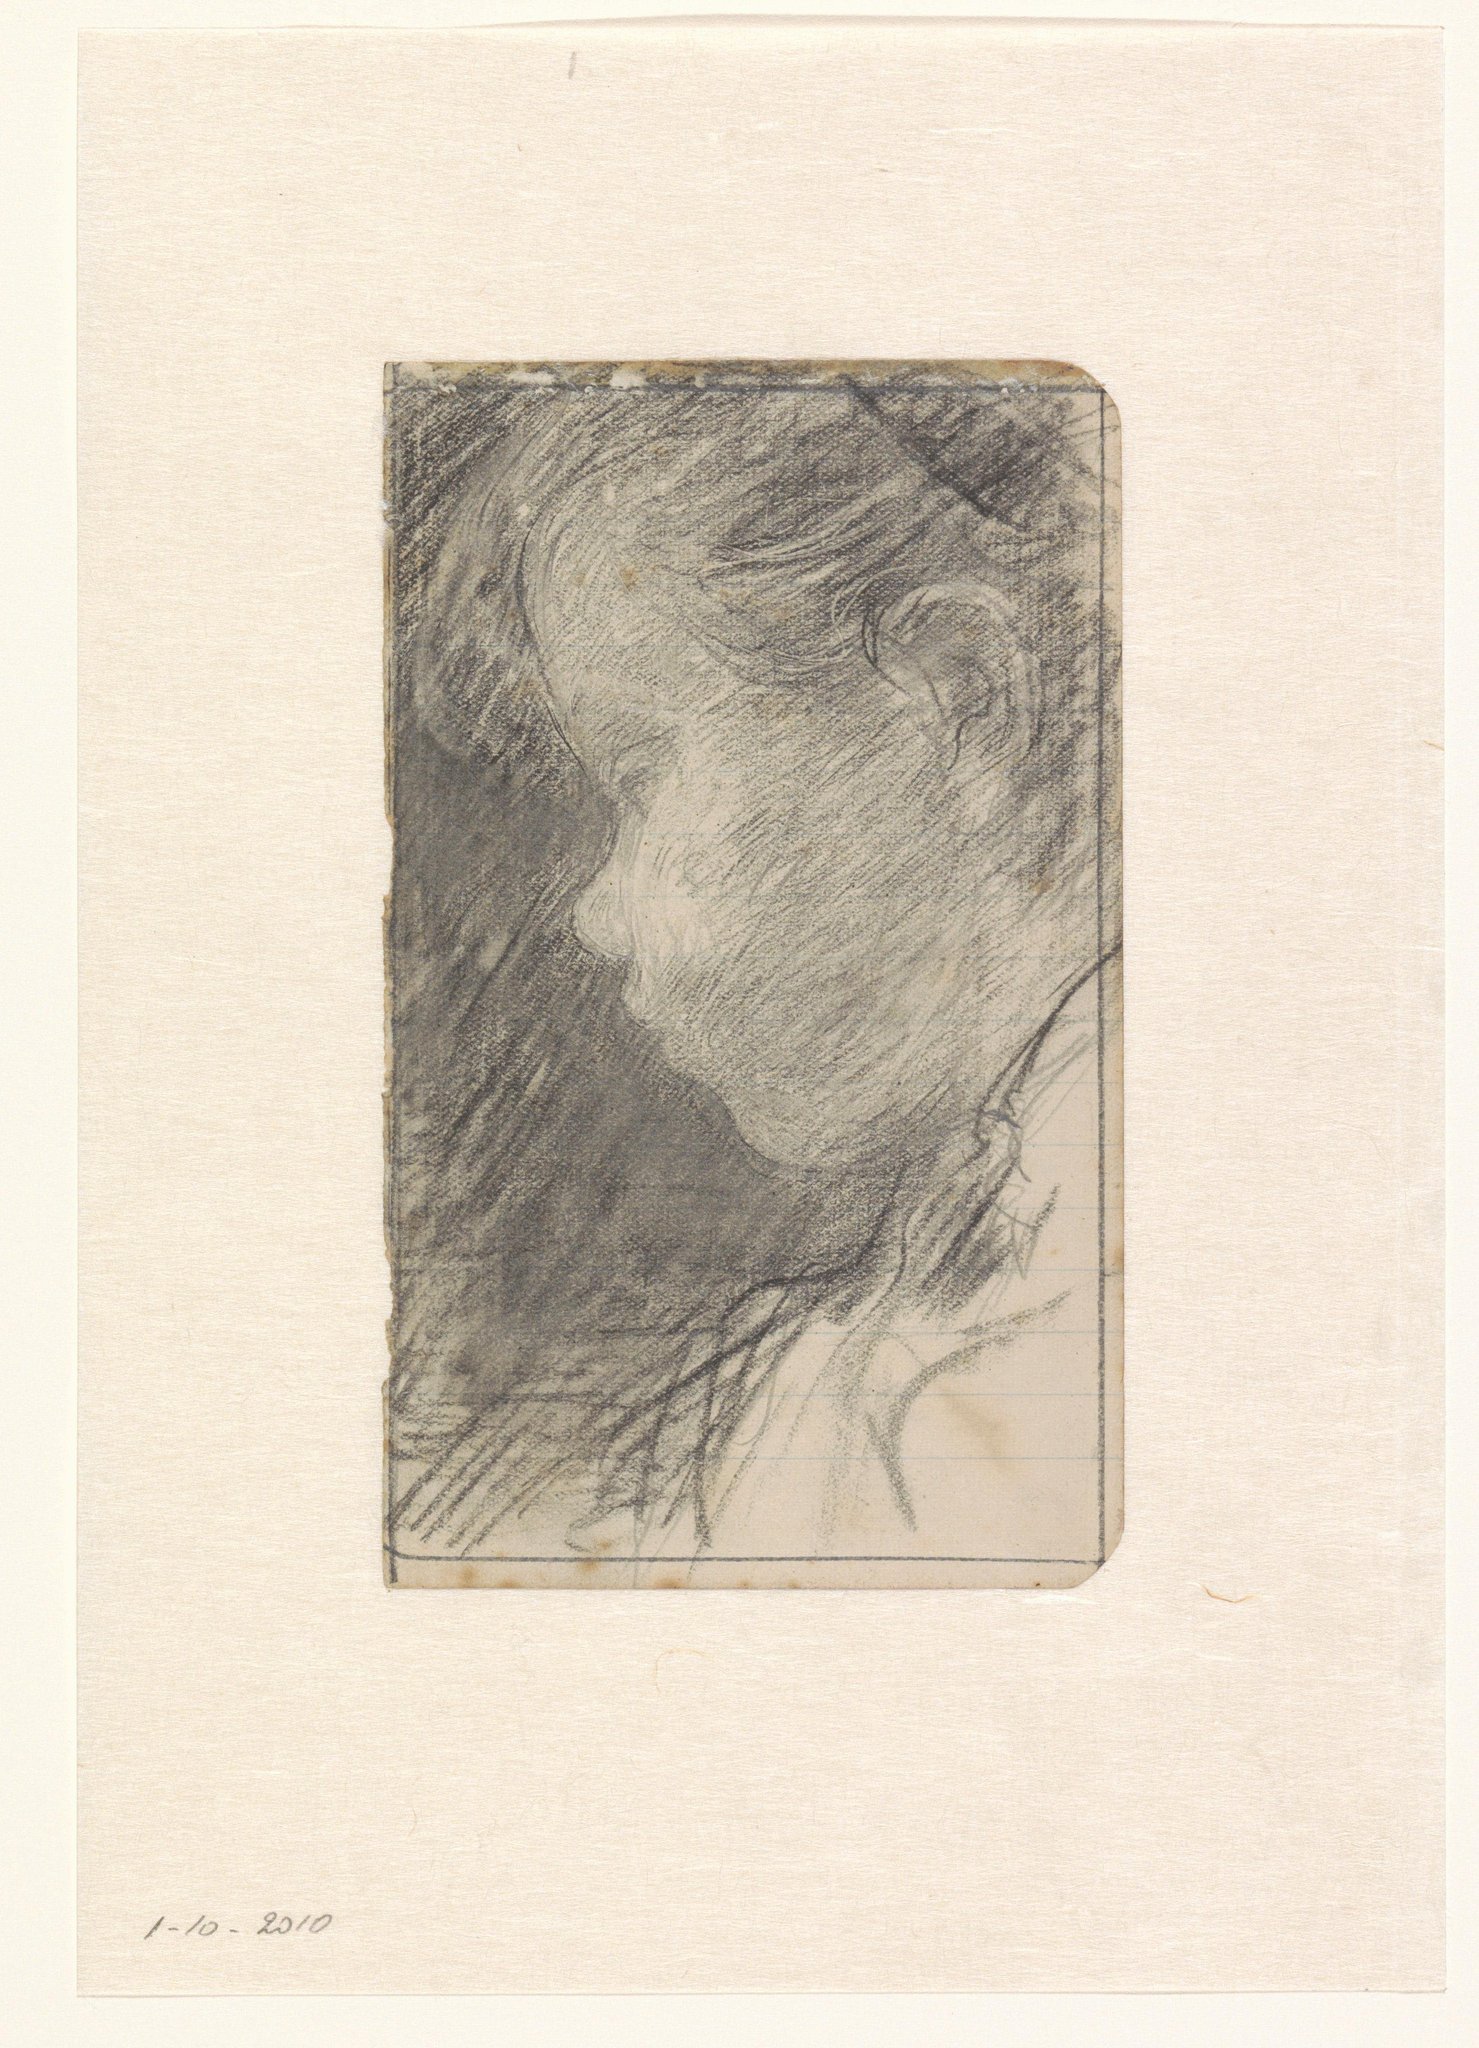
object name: drawing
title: Kinderkopje, naar links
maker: jan veth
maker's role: designer, draughtsman, painter, print maker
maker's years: 1864-1925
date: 1874-1925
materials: chalk, paper, pencil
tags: anonymous historical person portrayed alone